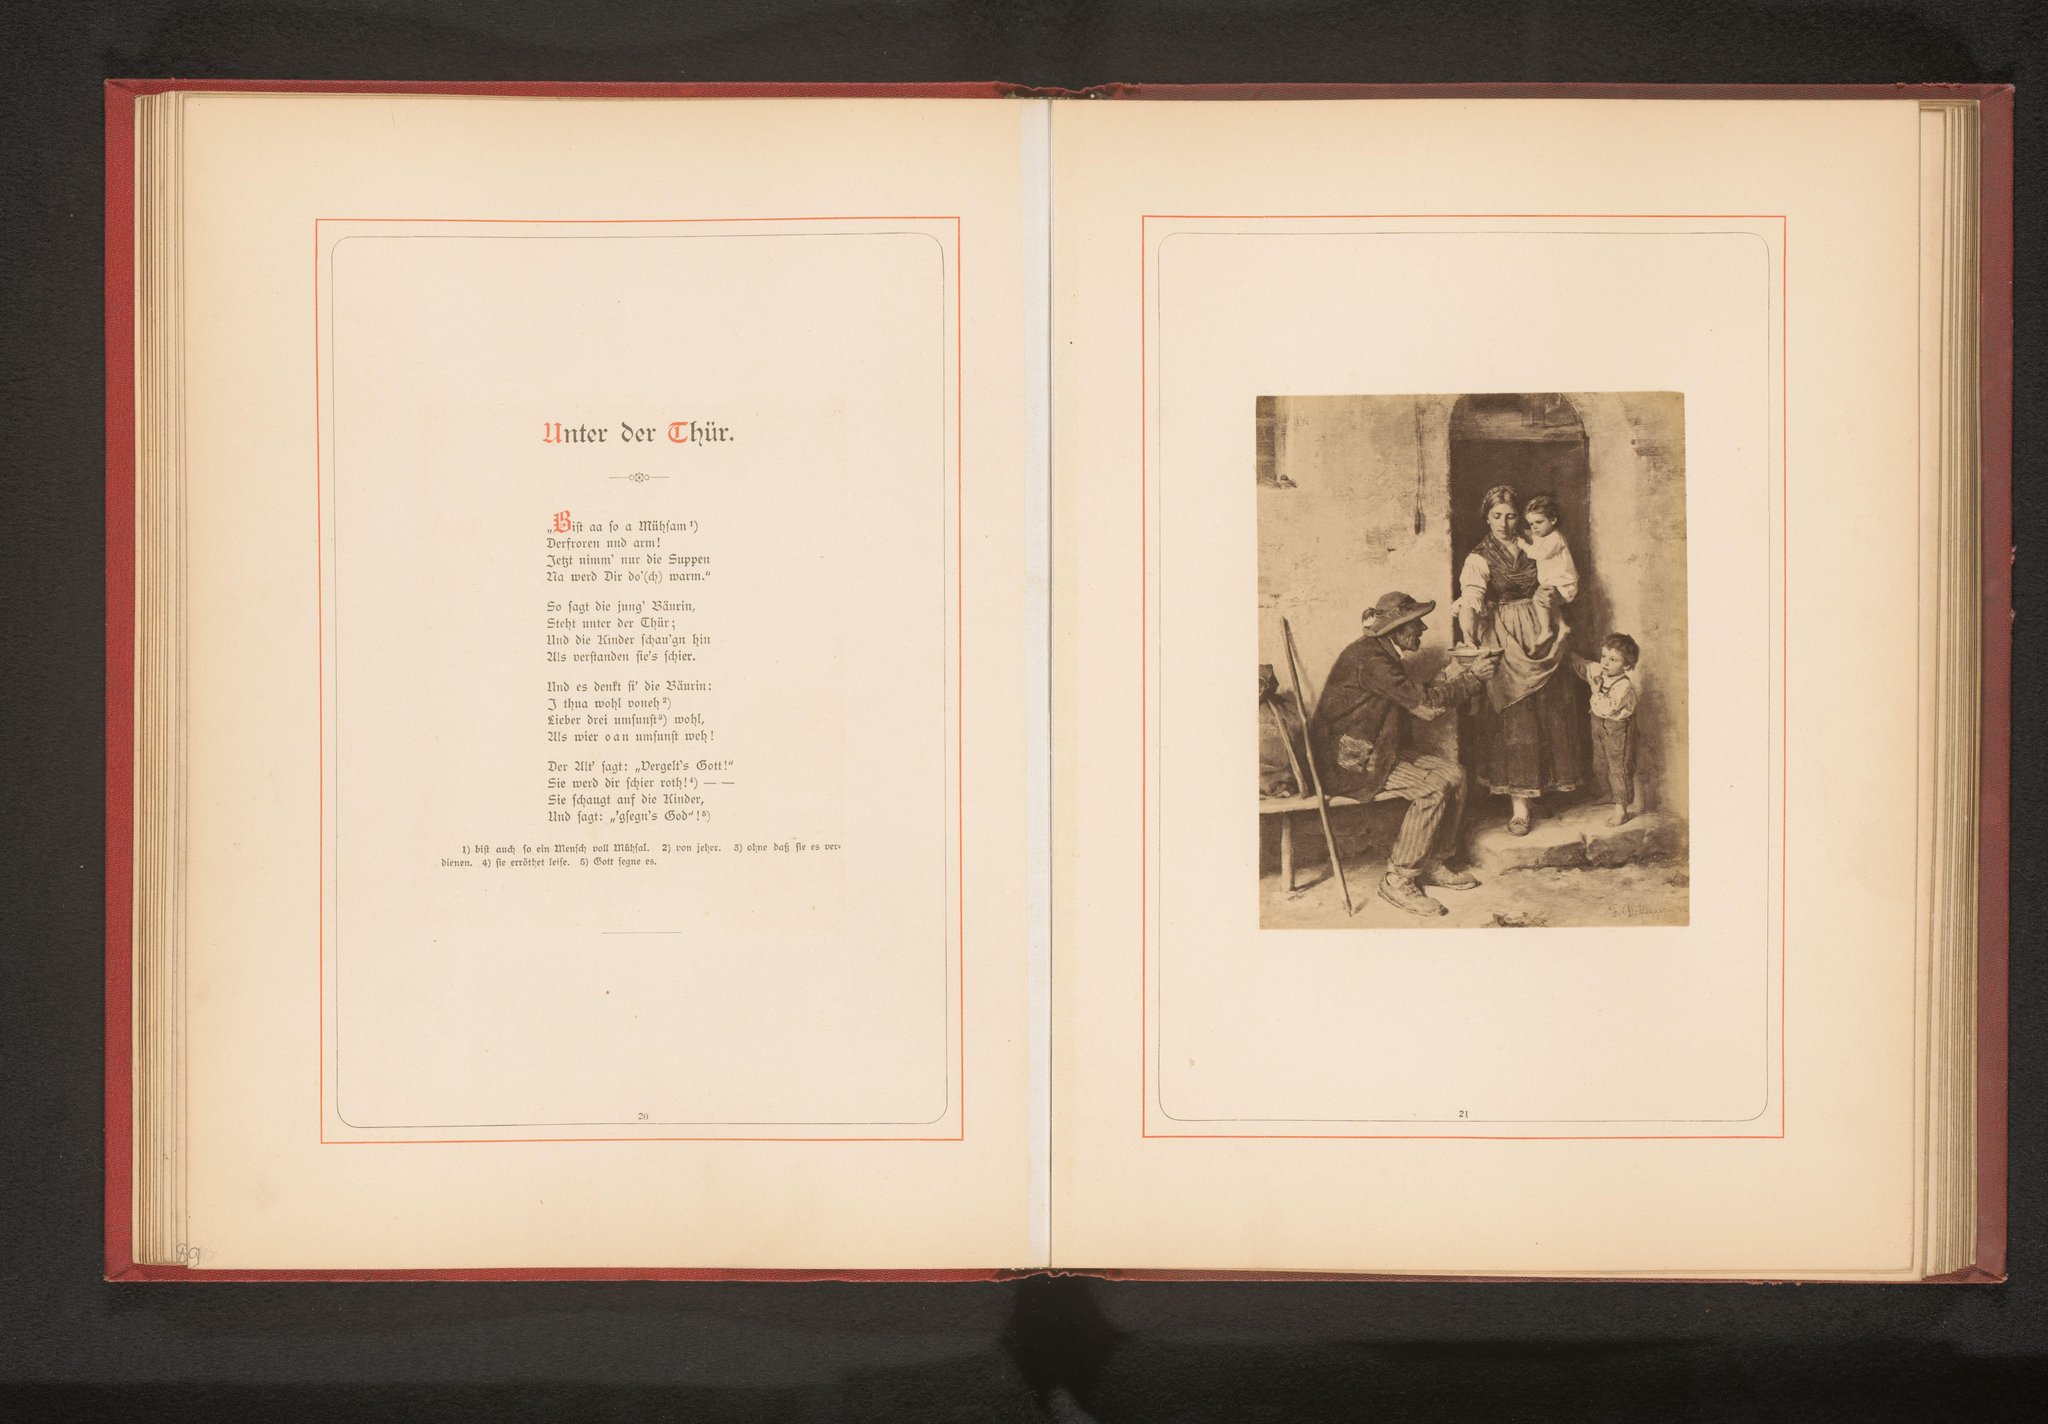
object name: reproduction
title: Fotoreproductie van een schilderij, voorstellende een vrouw geeft een oude man een kom soep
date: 1882-1885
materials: photographic support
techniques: albumen print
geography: germany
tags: old man, broth, soup, mother and child(ren), woman and child(ren) (family group)